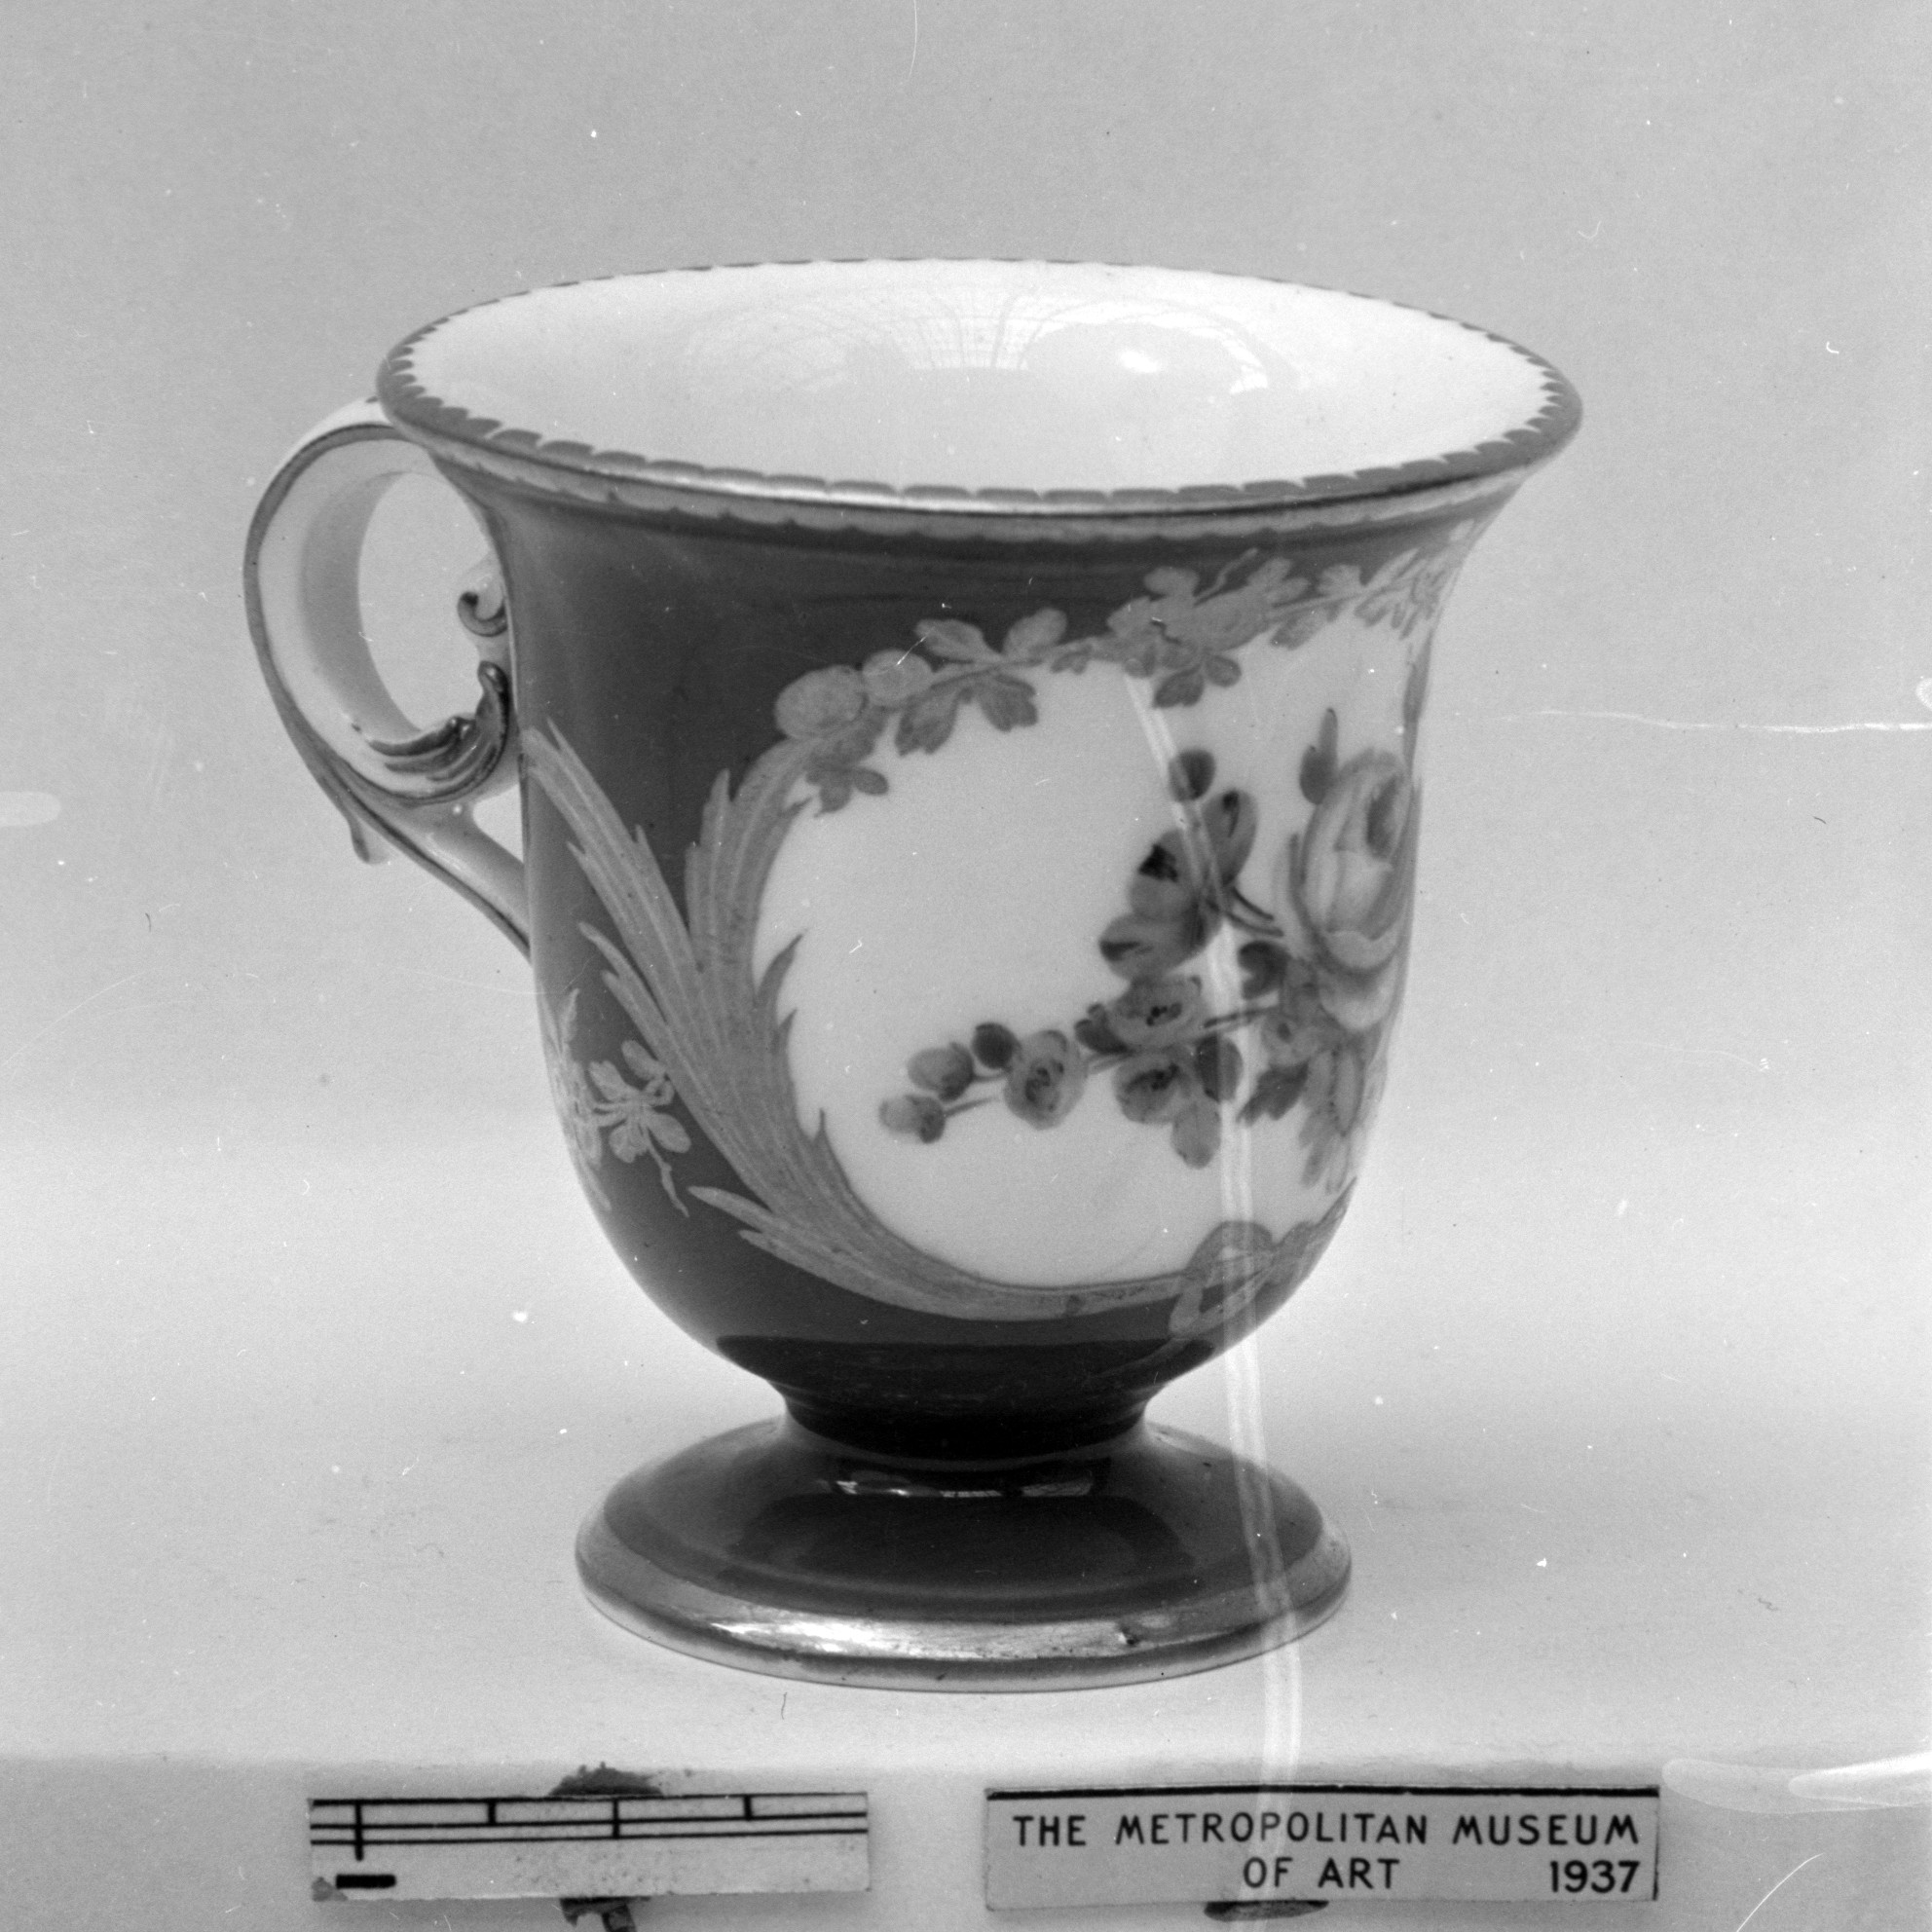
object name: ice cream cup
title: Ice cream cup (Tasse à glace) (part of a service)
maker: sèvres manufactory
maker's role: manufactory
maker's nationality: french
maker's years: 1740-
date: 1780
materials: soft paste porcelain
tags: flowers